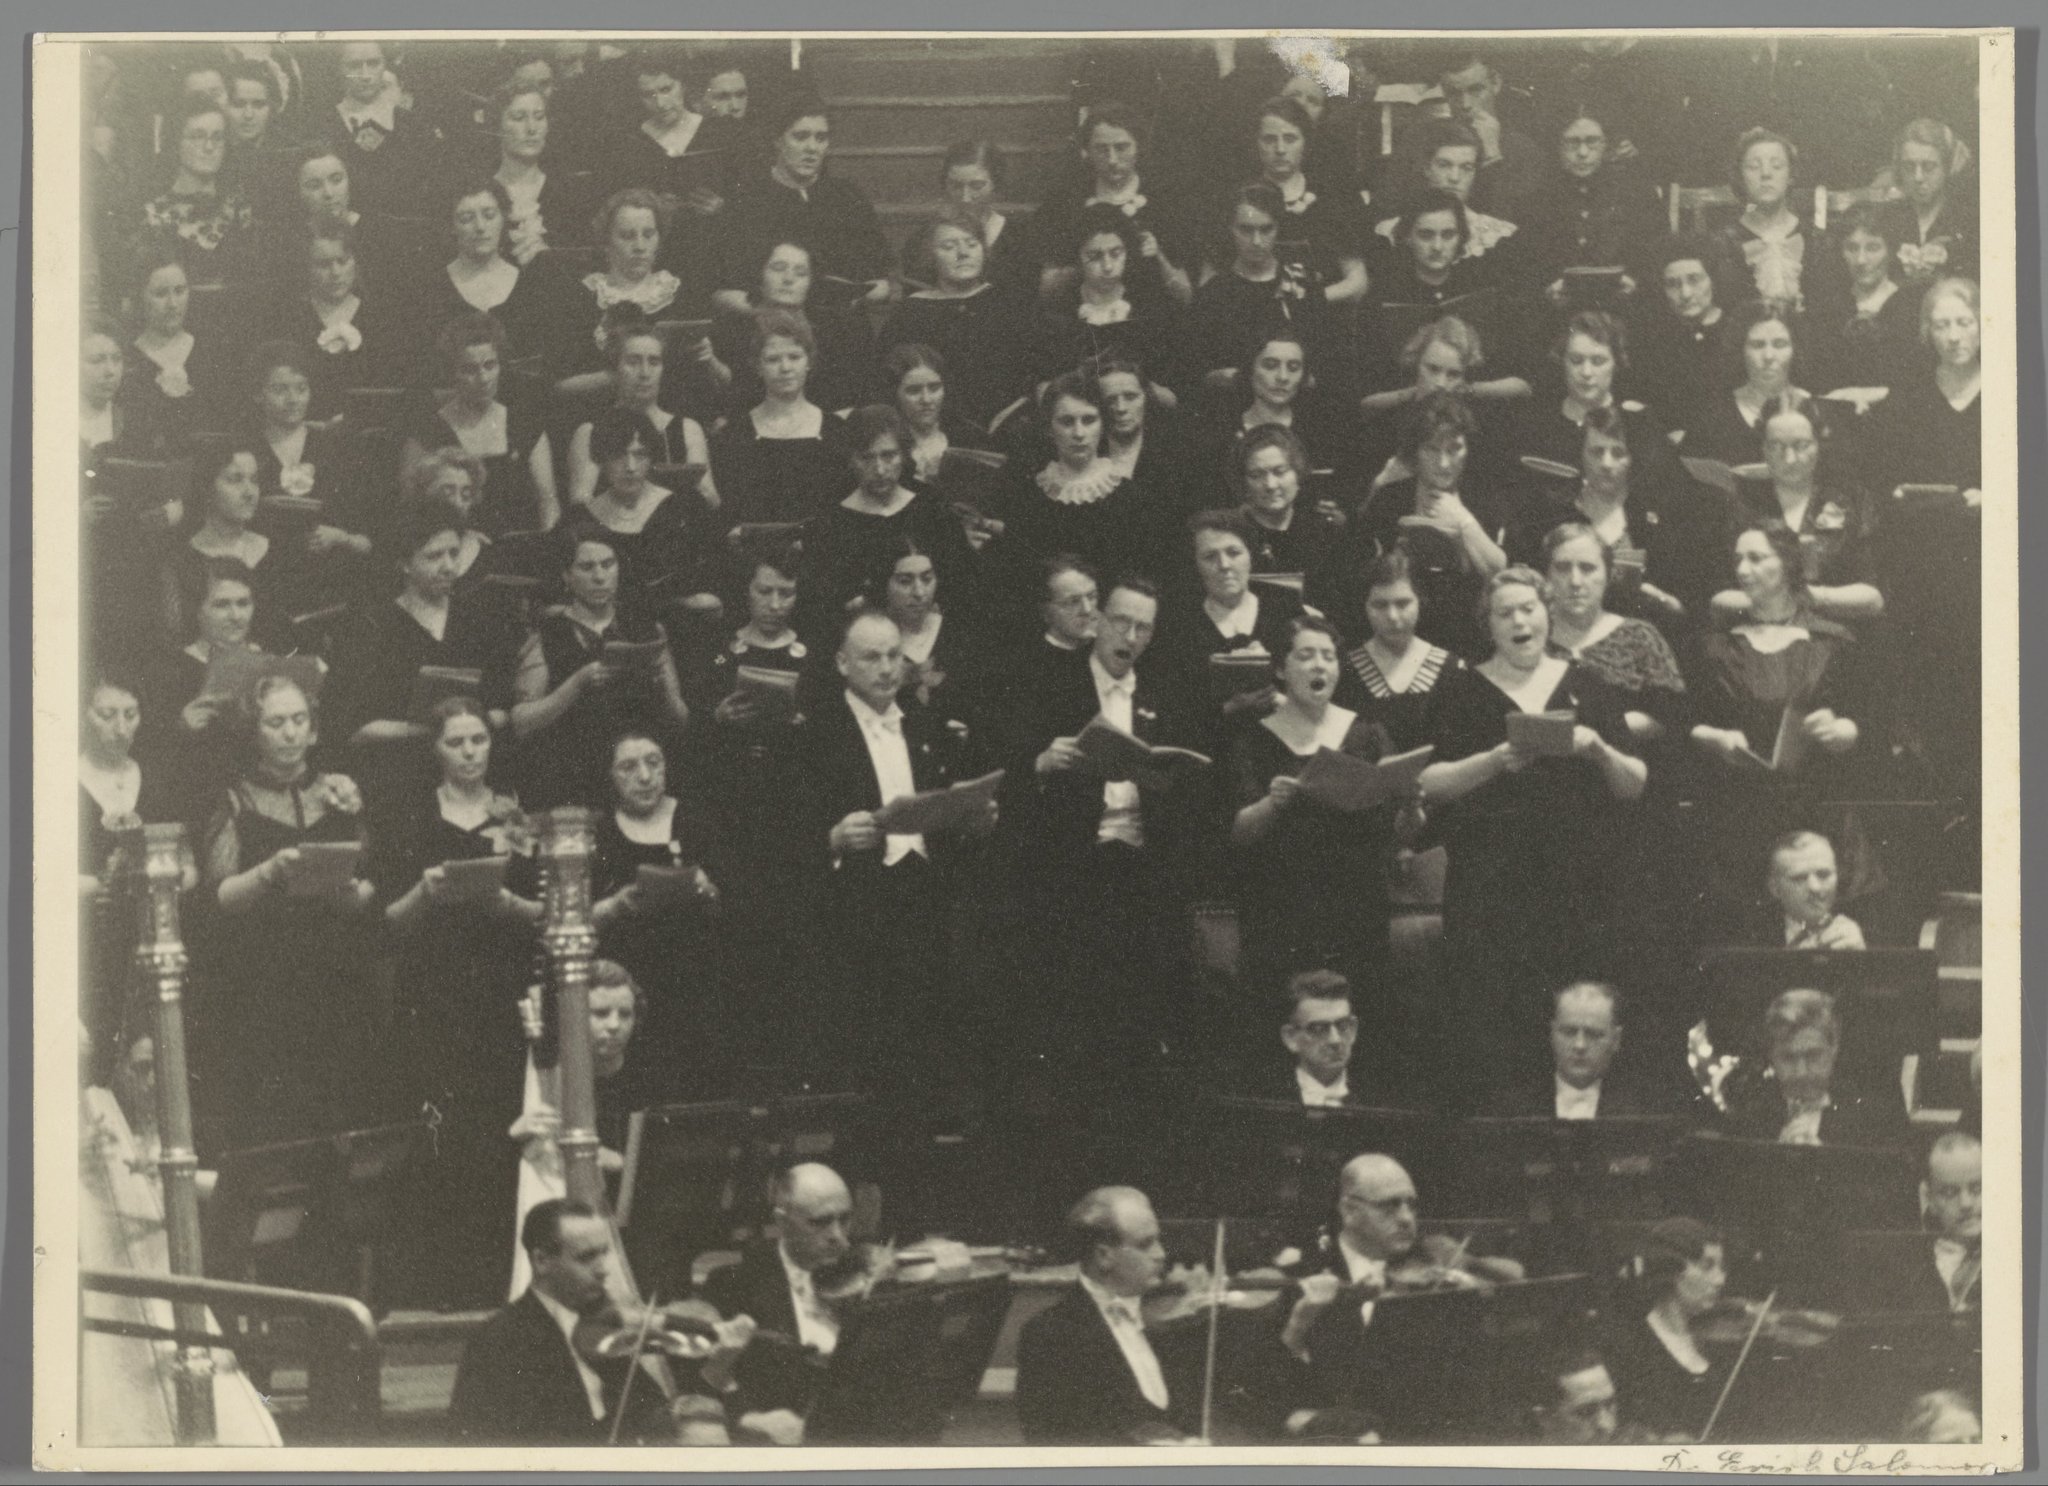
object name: photograph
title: Toonkunstkoor tijdens optreden in het Concertgebouw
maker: erich salomon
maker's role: fotograaf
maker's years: 1886-1944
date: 1930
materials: paper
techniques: gelatin silver print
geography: amsterdam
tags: choir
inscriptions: inscription: ‘foto afkomstig liquidatie firma A[...] D[...] A'dam 1961’, signature: ‘Dr. Erich Salomon’, inscription: ‘Toonkunstkoor’, stamp: ‘Photo Dr. Erich Salomon/ Den Haag/ van Alkemadelaan 350. Tel. 774570’